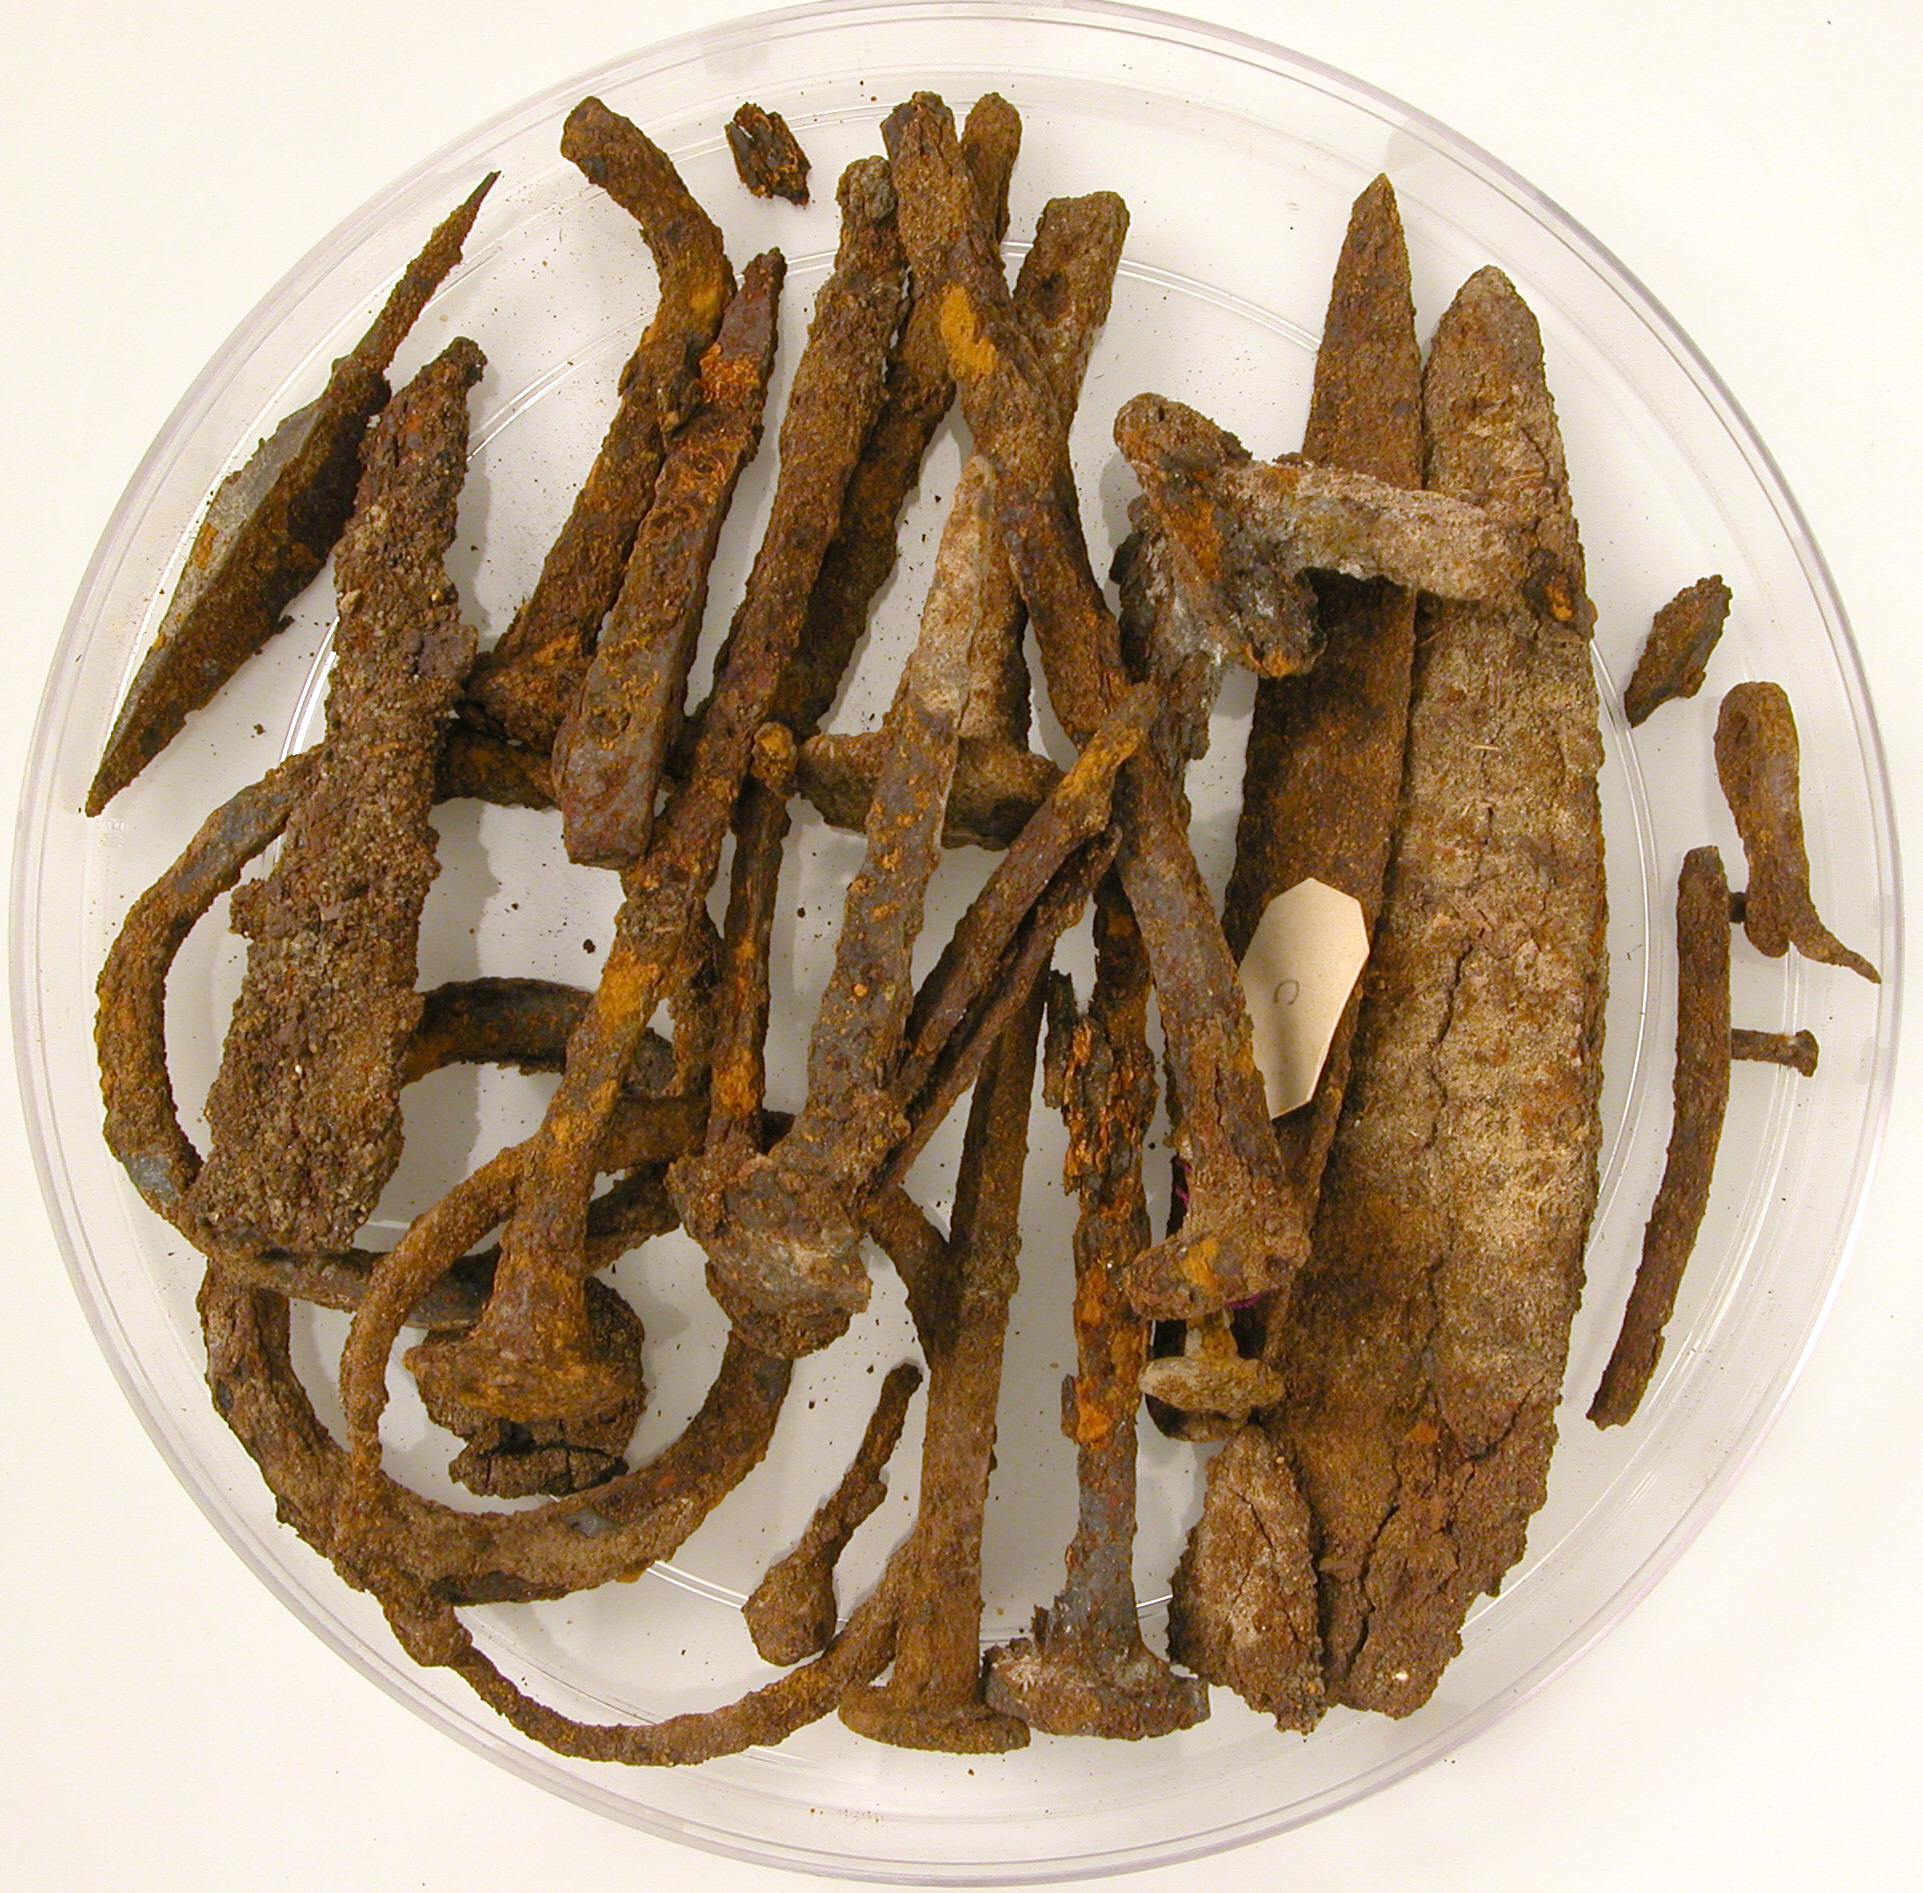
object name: fragment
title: Fragments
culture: coptic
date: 301-700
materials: iron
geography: egypt